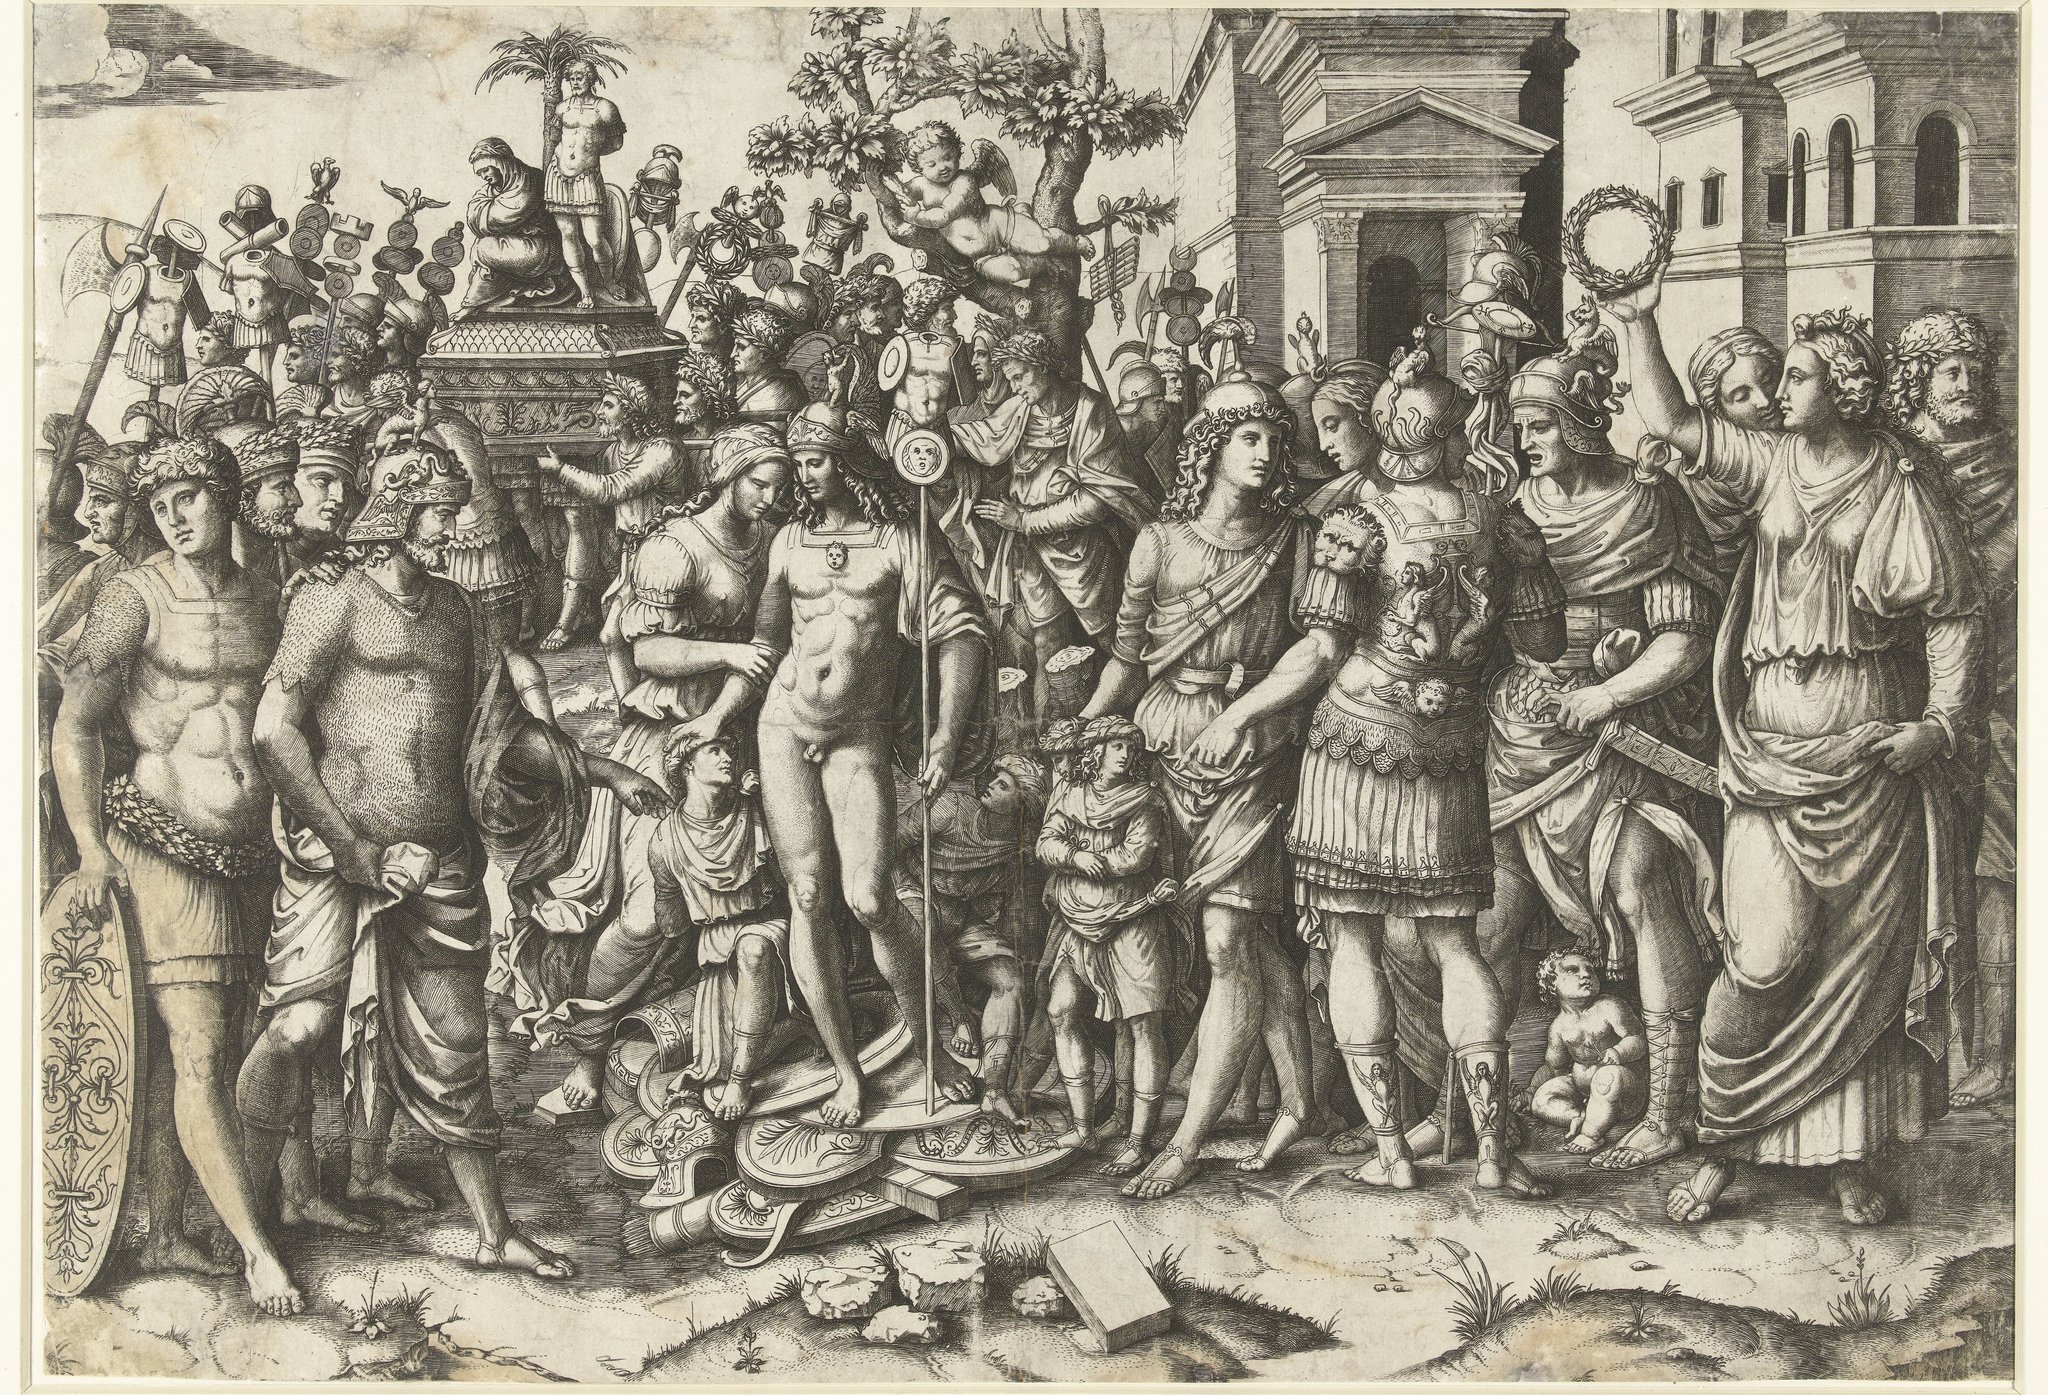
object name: print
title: Triomftocht van Romeinse keizer met soldaten en buitgemaakte wapenrustingen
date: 1510-1527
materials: paper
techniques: engraving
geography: italy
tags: triumphs (allegorical and symbolic), conqueror triumphing, triumphal entry of victor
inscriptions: collector's mark: Lugt 240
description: Prent mogelijk naar ontwerp van Andrea Mantegna.